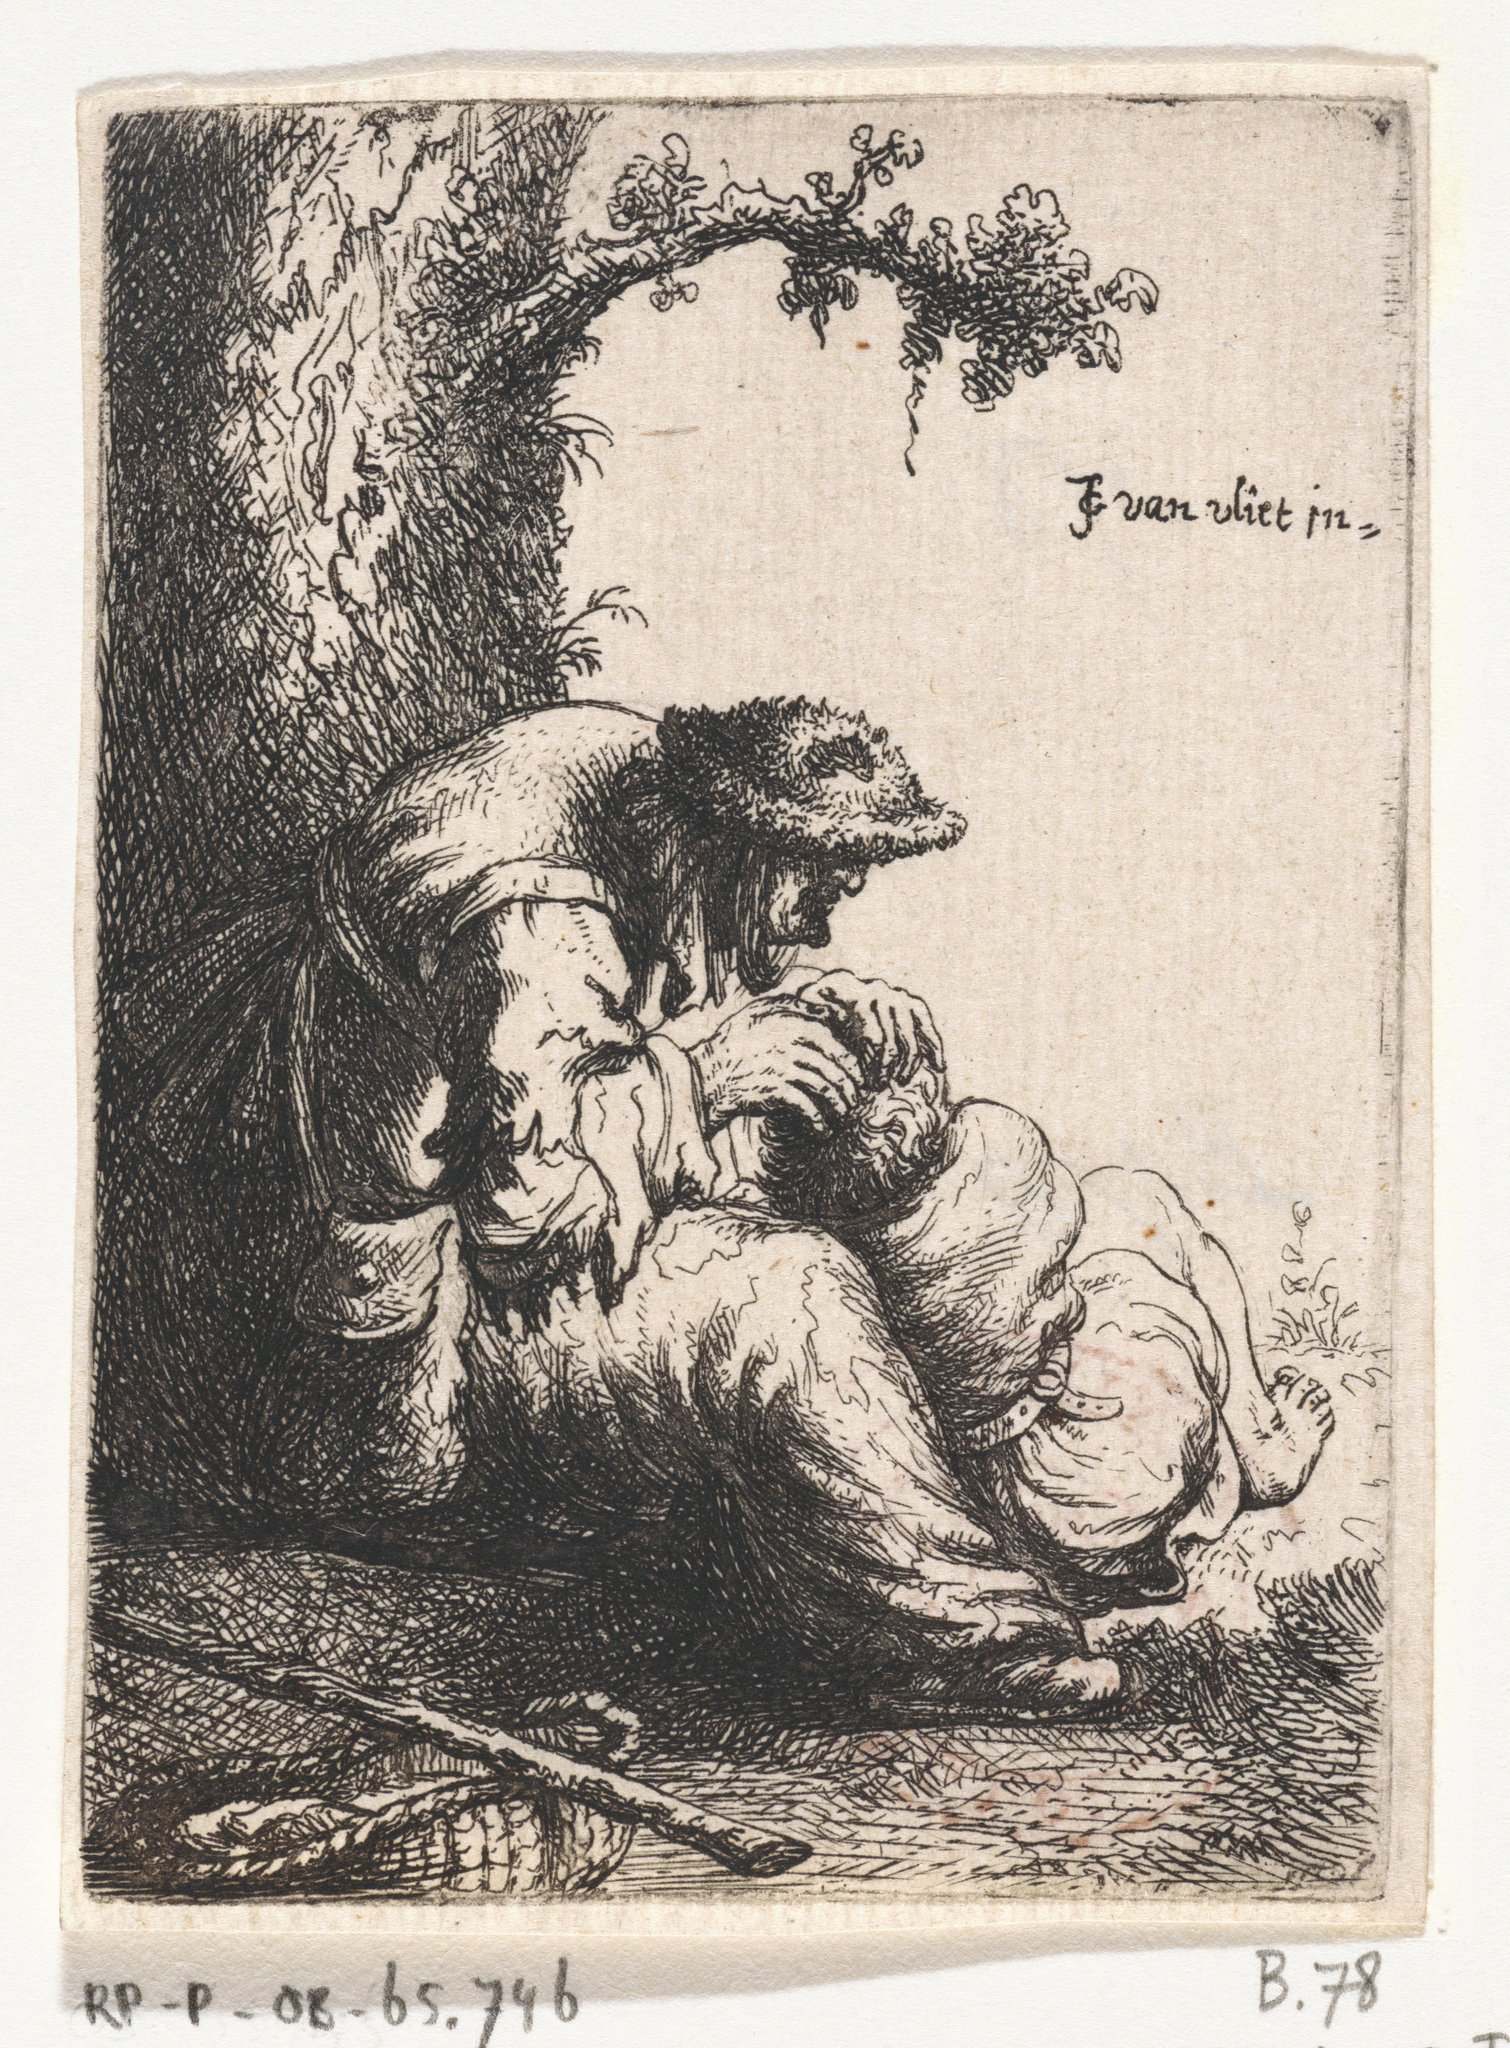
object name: print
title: Vrouw die een jongen vlooit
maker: jan gillisz. van vliet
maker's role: draughtsman, painter, print maker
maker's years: 1600-1668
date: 1632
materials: paper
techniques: etching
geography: leiden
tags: looking for fleas - aa - female human figure, walking-stick, staff, container made of plant material other than wood: basket, beggar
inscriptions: collector's mark: Lugt 240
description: Een vrouwelijke bedelaar vlooit een jongen onder een boom. Op de voorgrond liggen een mand en een wandelstok.